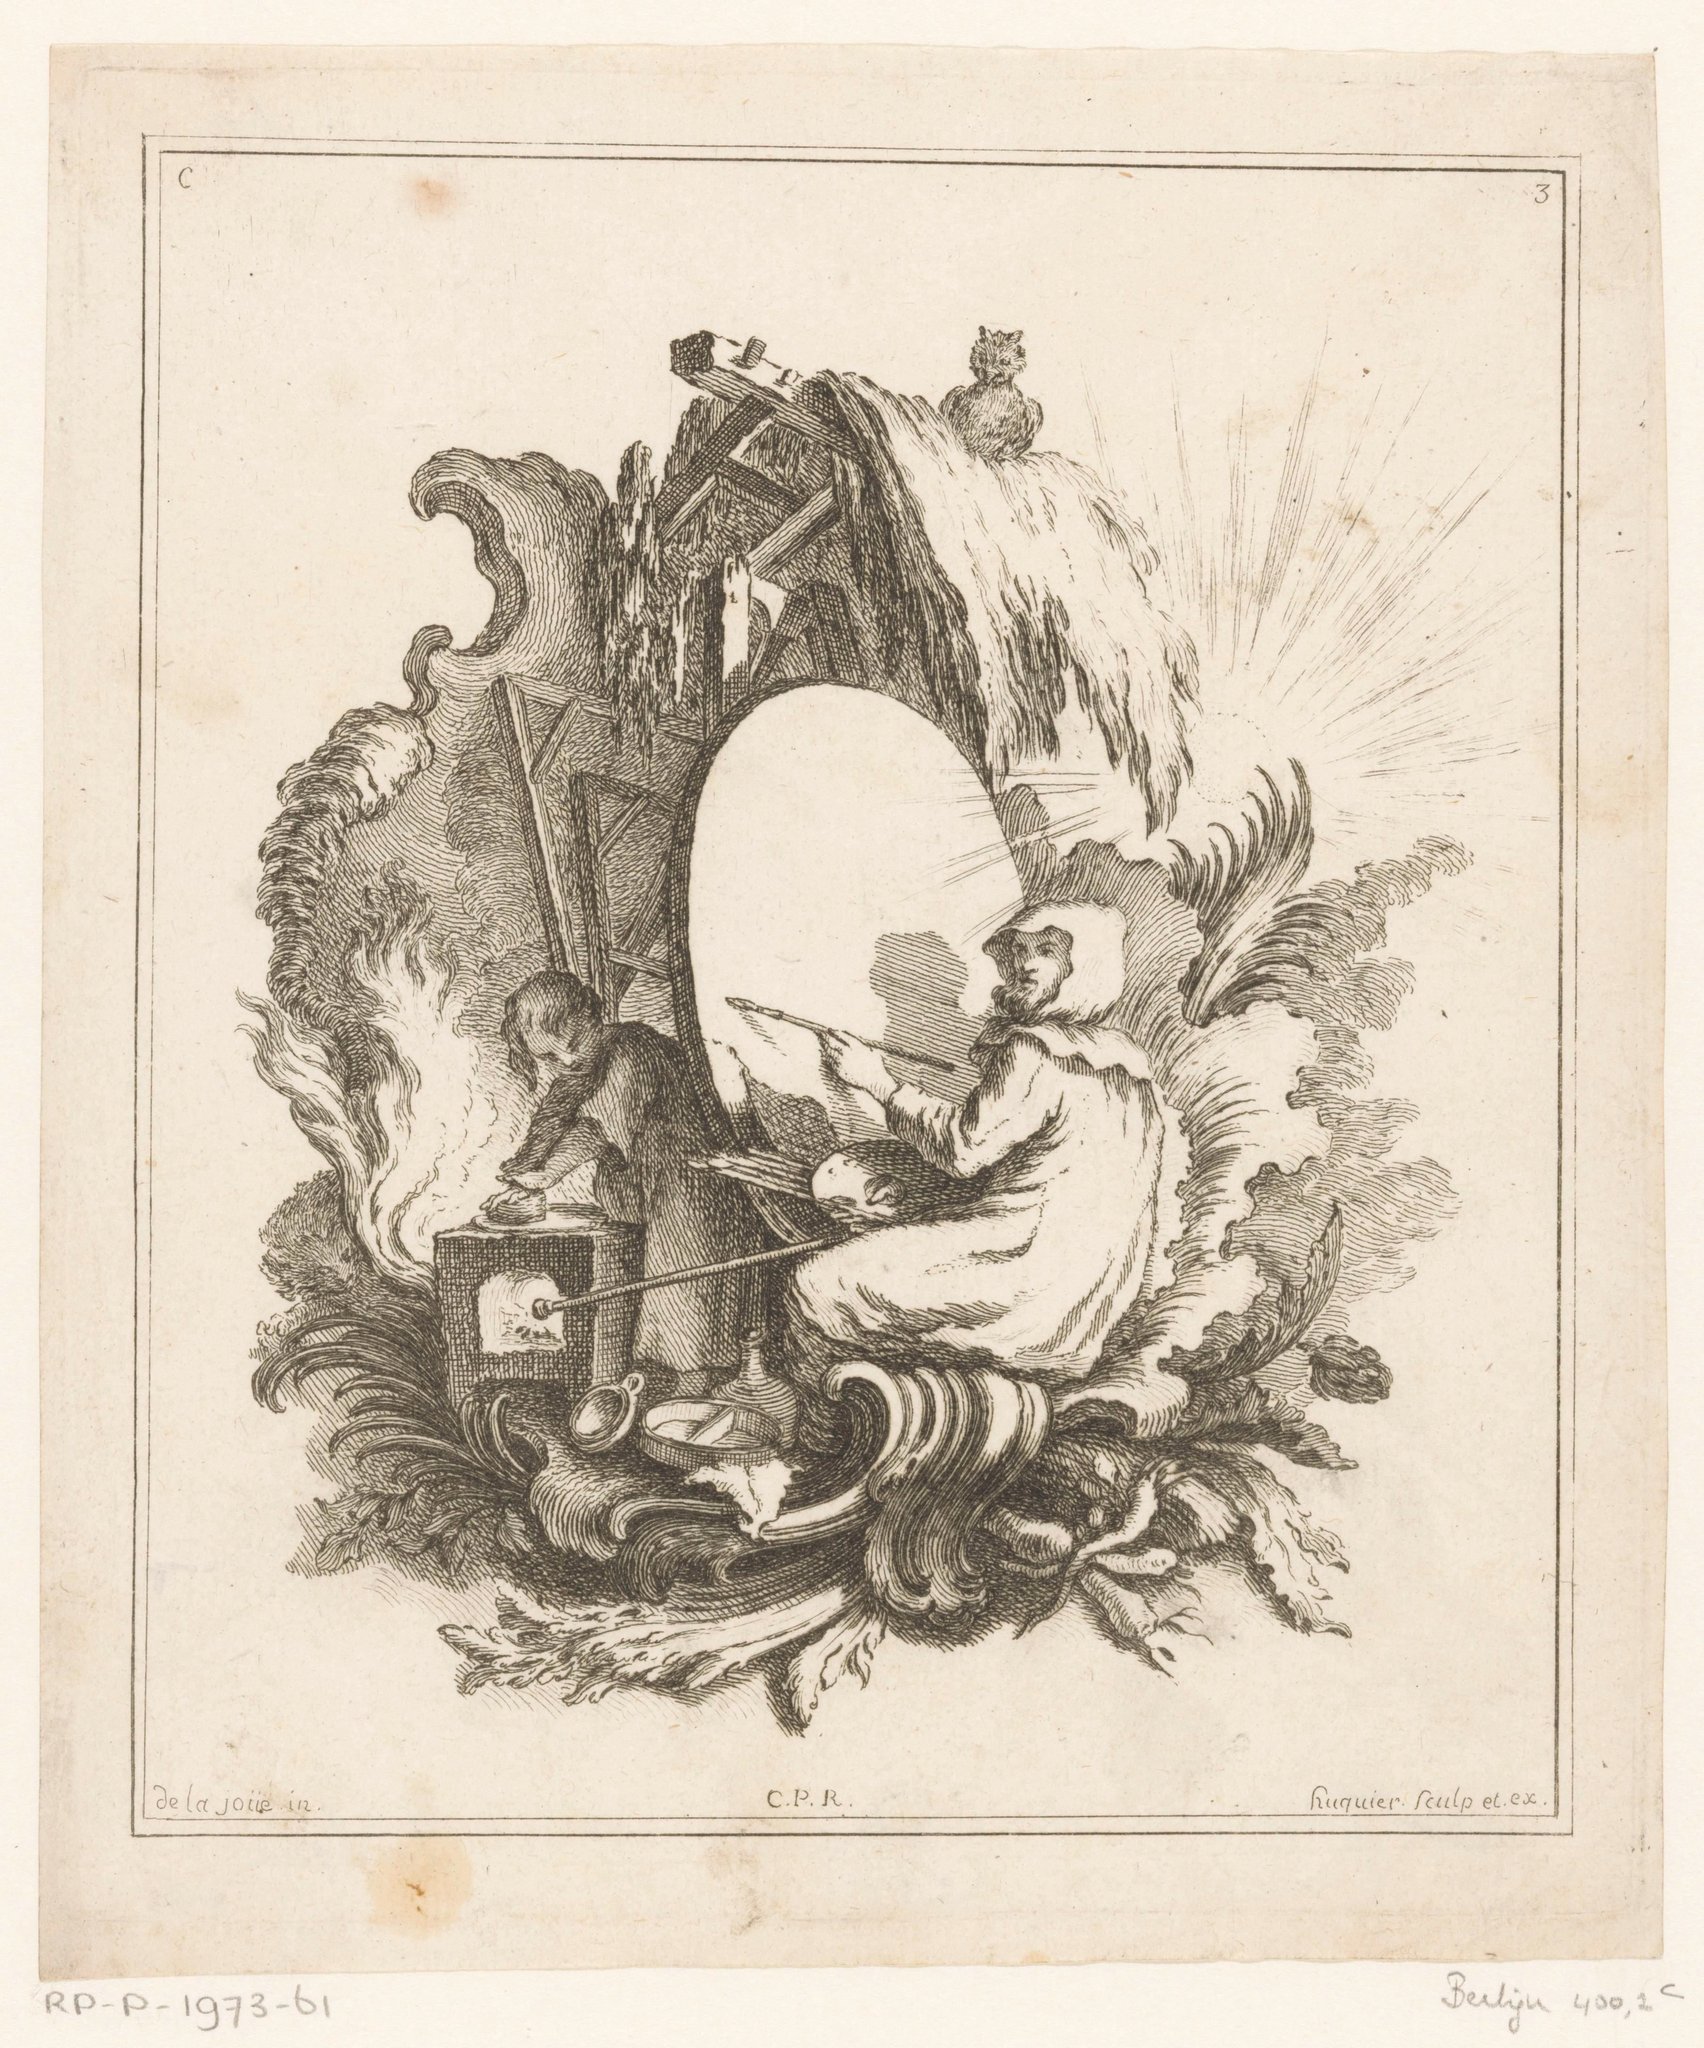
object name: ornament print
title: Schilder aan het werk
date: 1705-1761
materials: paper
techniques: etching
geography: paris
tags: painter at work, in his studio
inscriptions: collector's mark: Lugt 2228, collector's mark: Lugt 2760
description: Een schilder is aan het werk op een ovaal doek. Daarachter verwarmt een jongen iets op vuur. De voorstelling wordt omringd door rocaille ornamenten en rechts schijnt de zon.